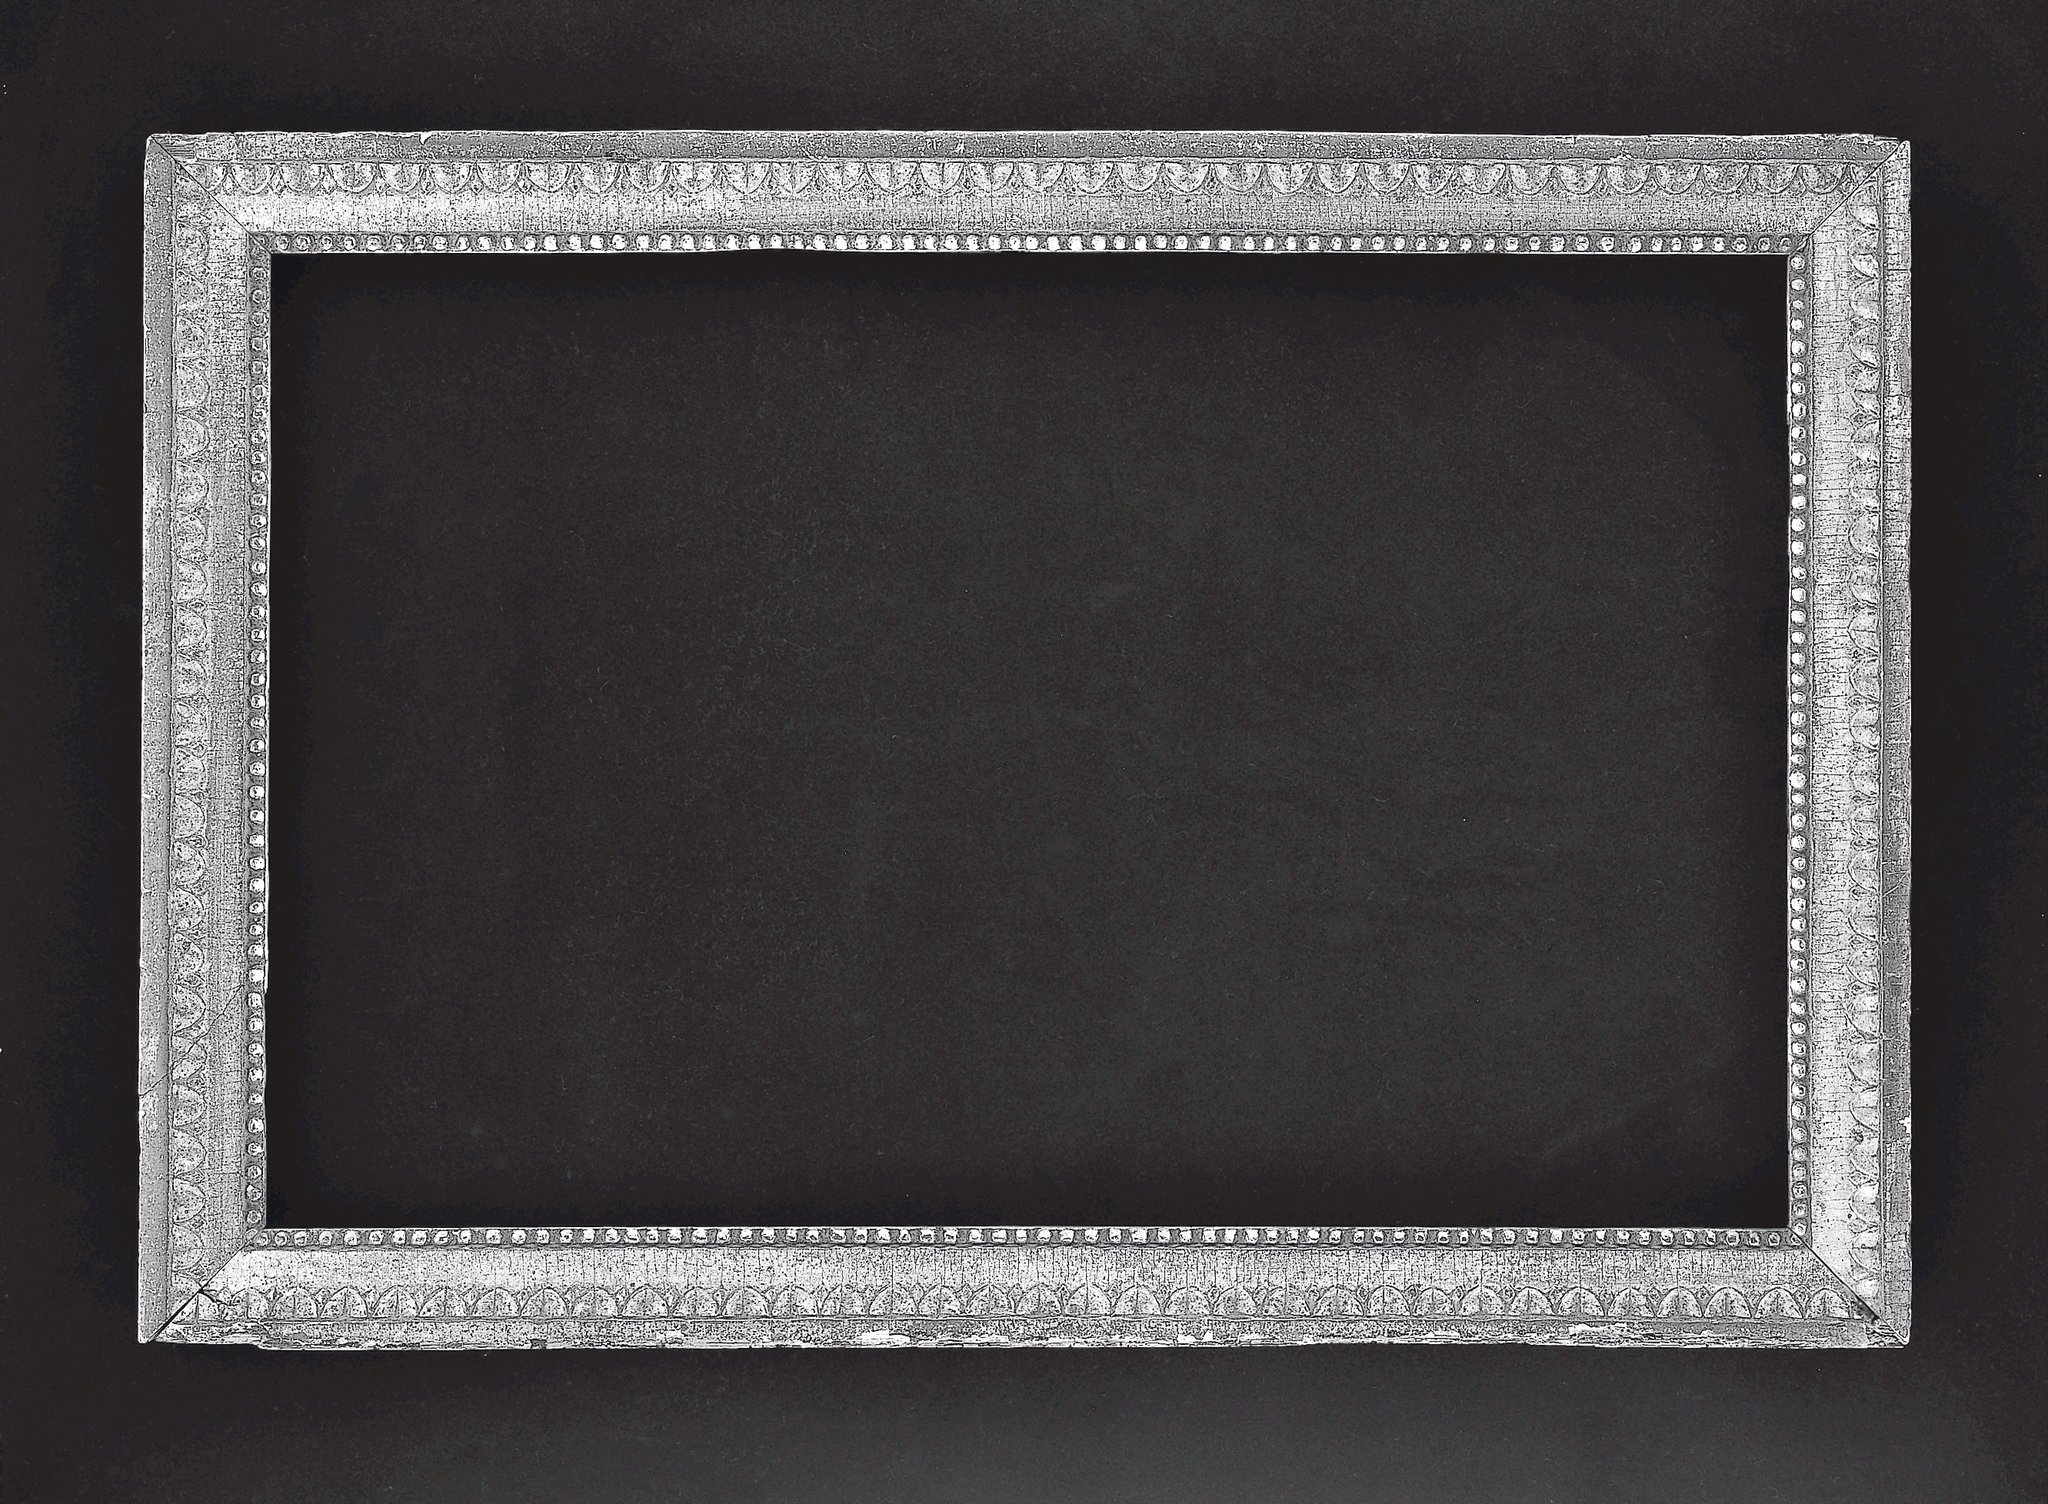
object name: frame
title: Cassetta frame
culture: french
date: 1780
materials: wood